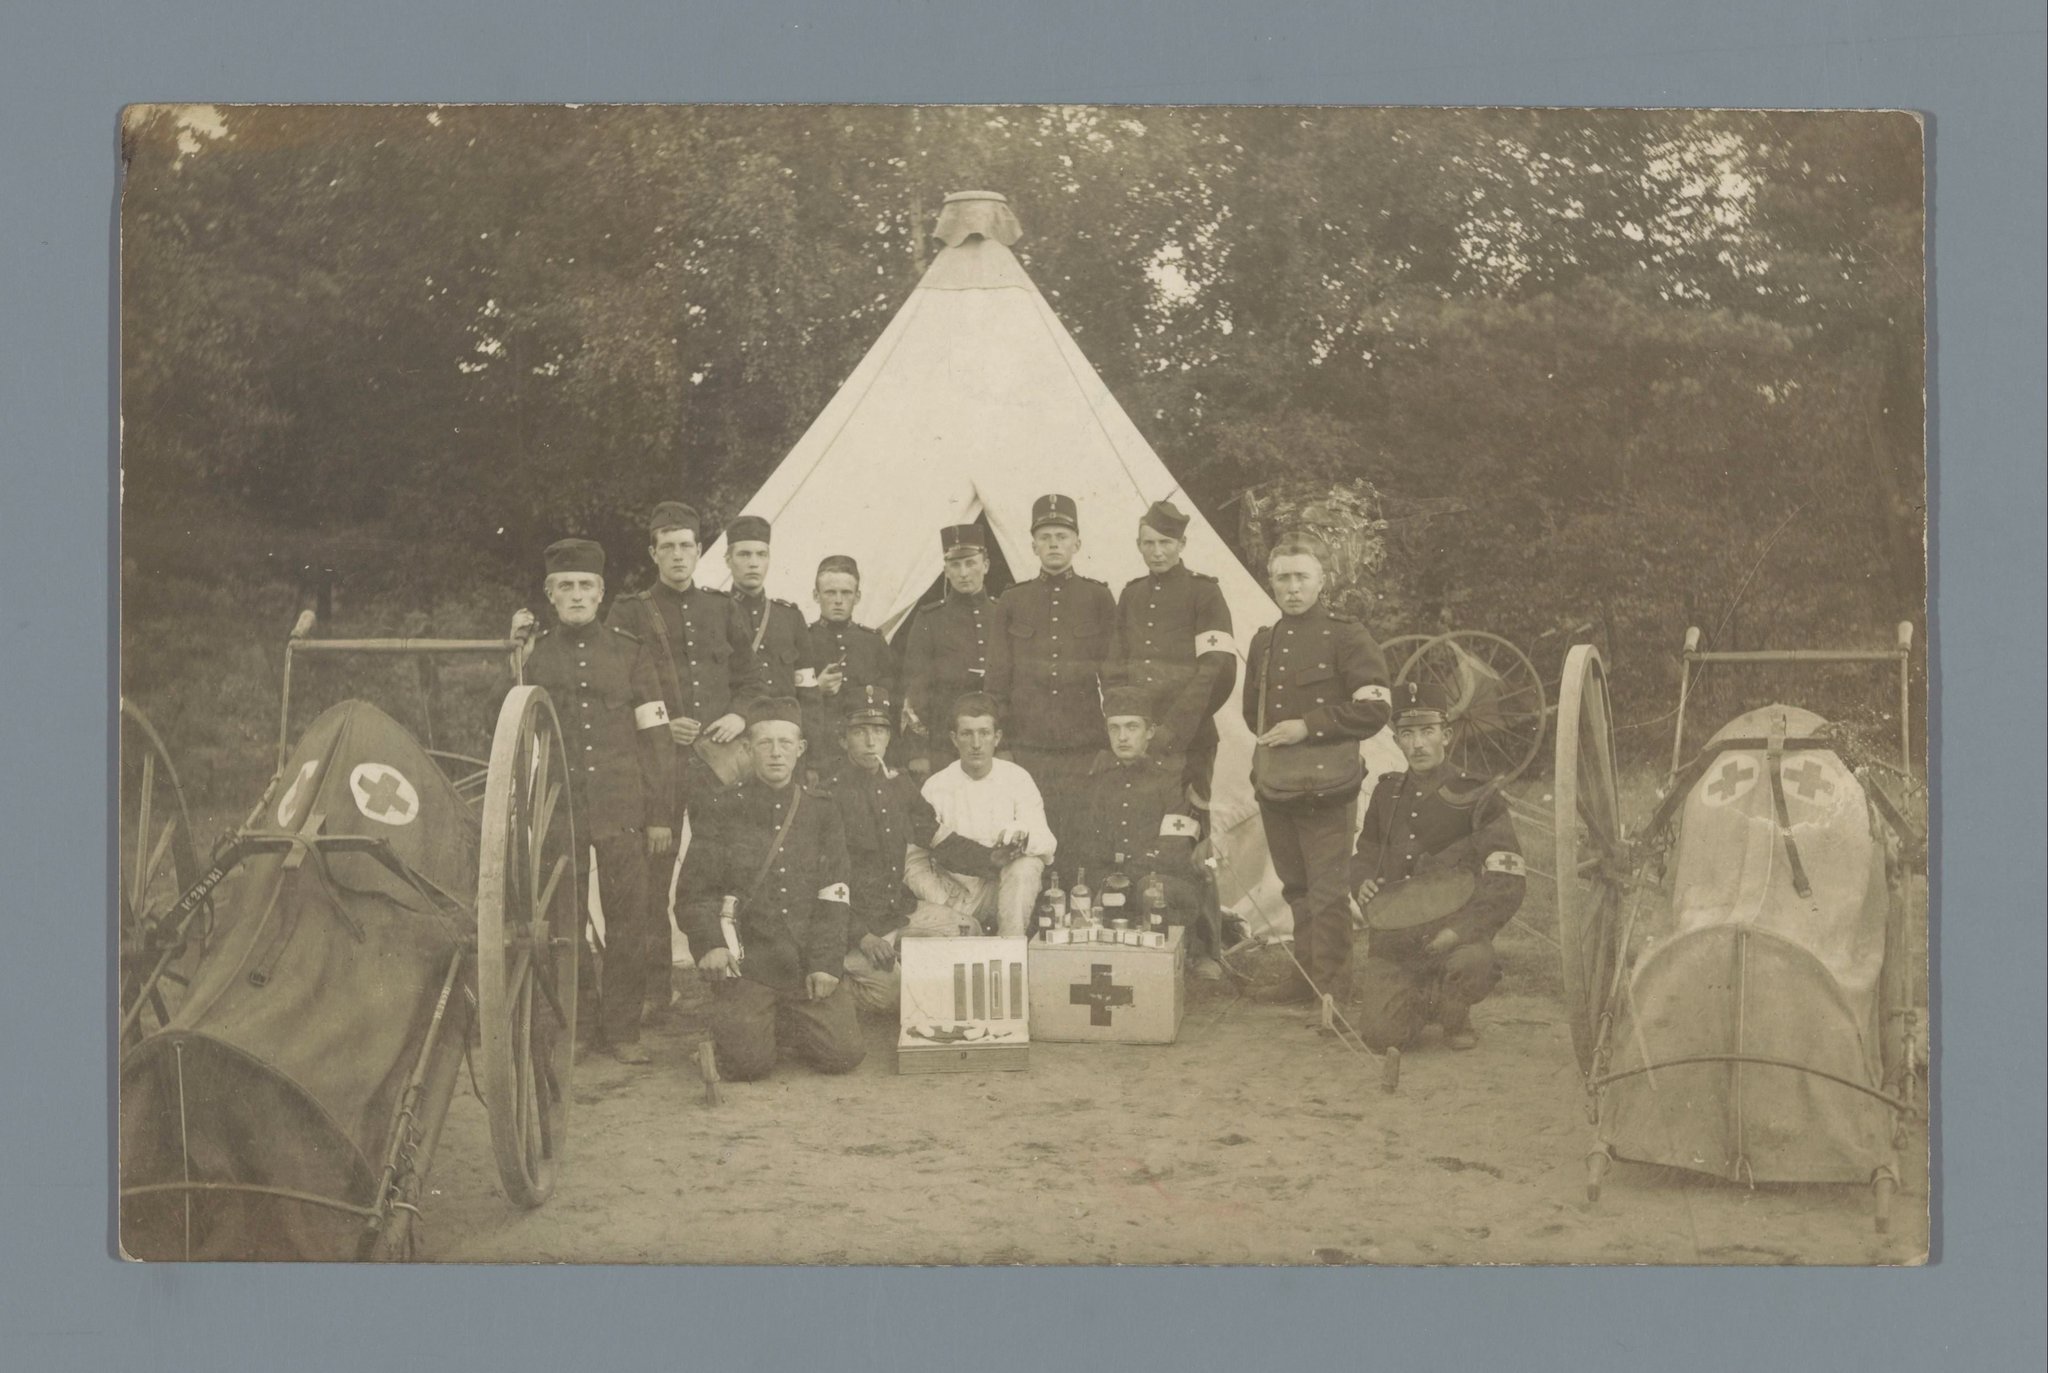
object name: photograph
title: Groepsportret van broeders van het Rode Kruis voor een tent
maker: Anonymous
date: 1910-1918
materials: photographic support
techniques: gelatin silver print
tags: medical aid and nursing of the sick and wounded in a field-hospital, male nurse ~ hospital